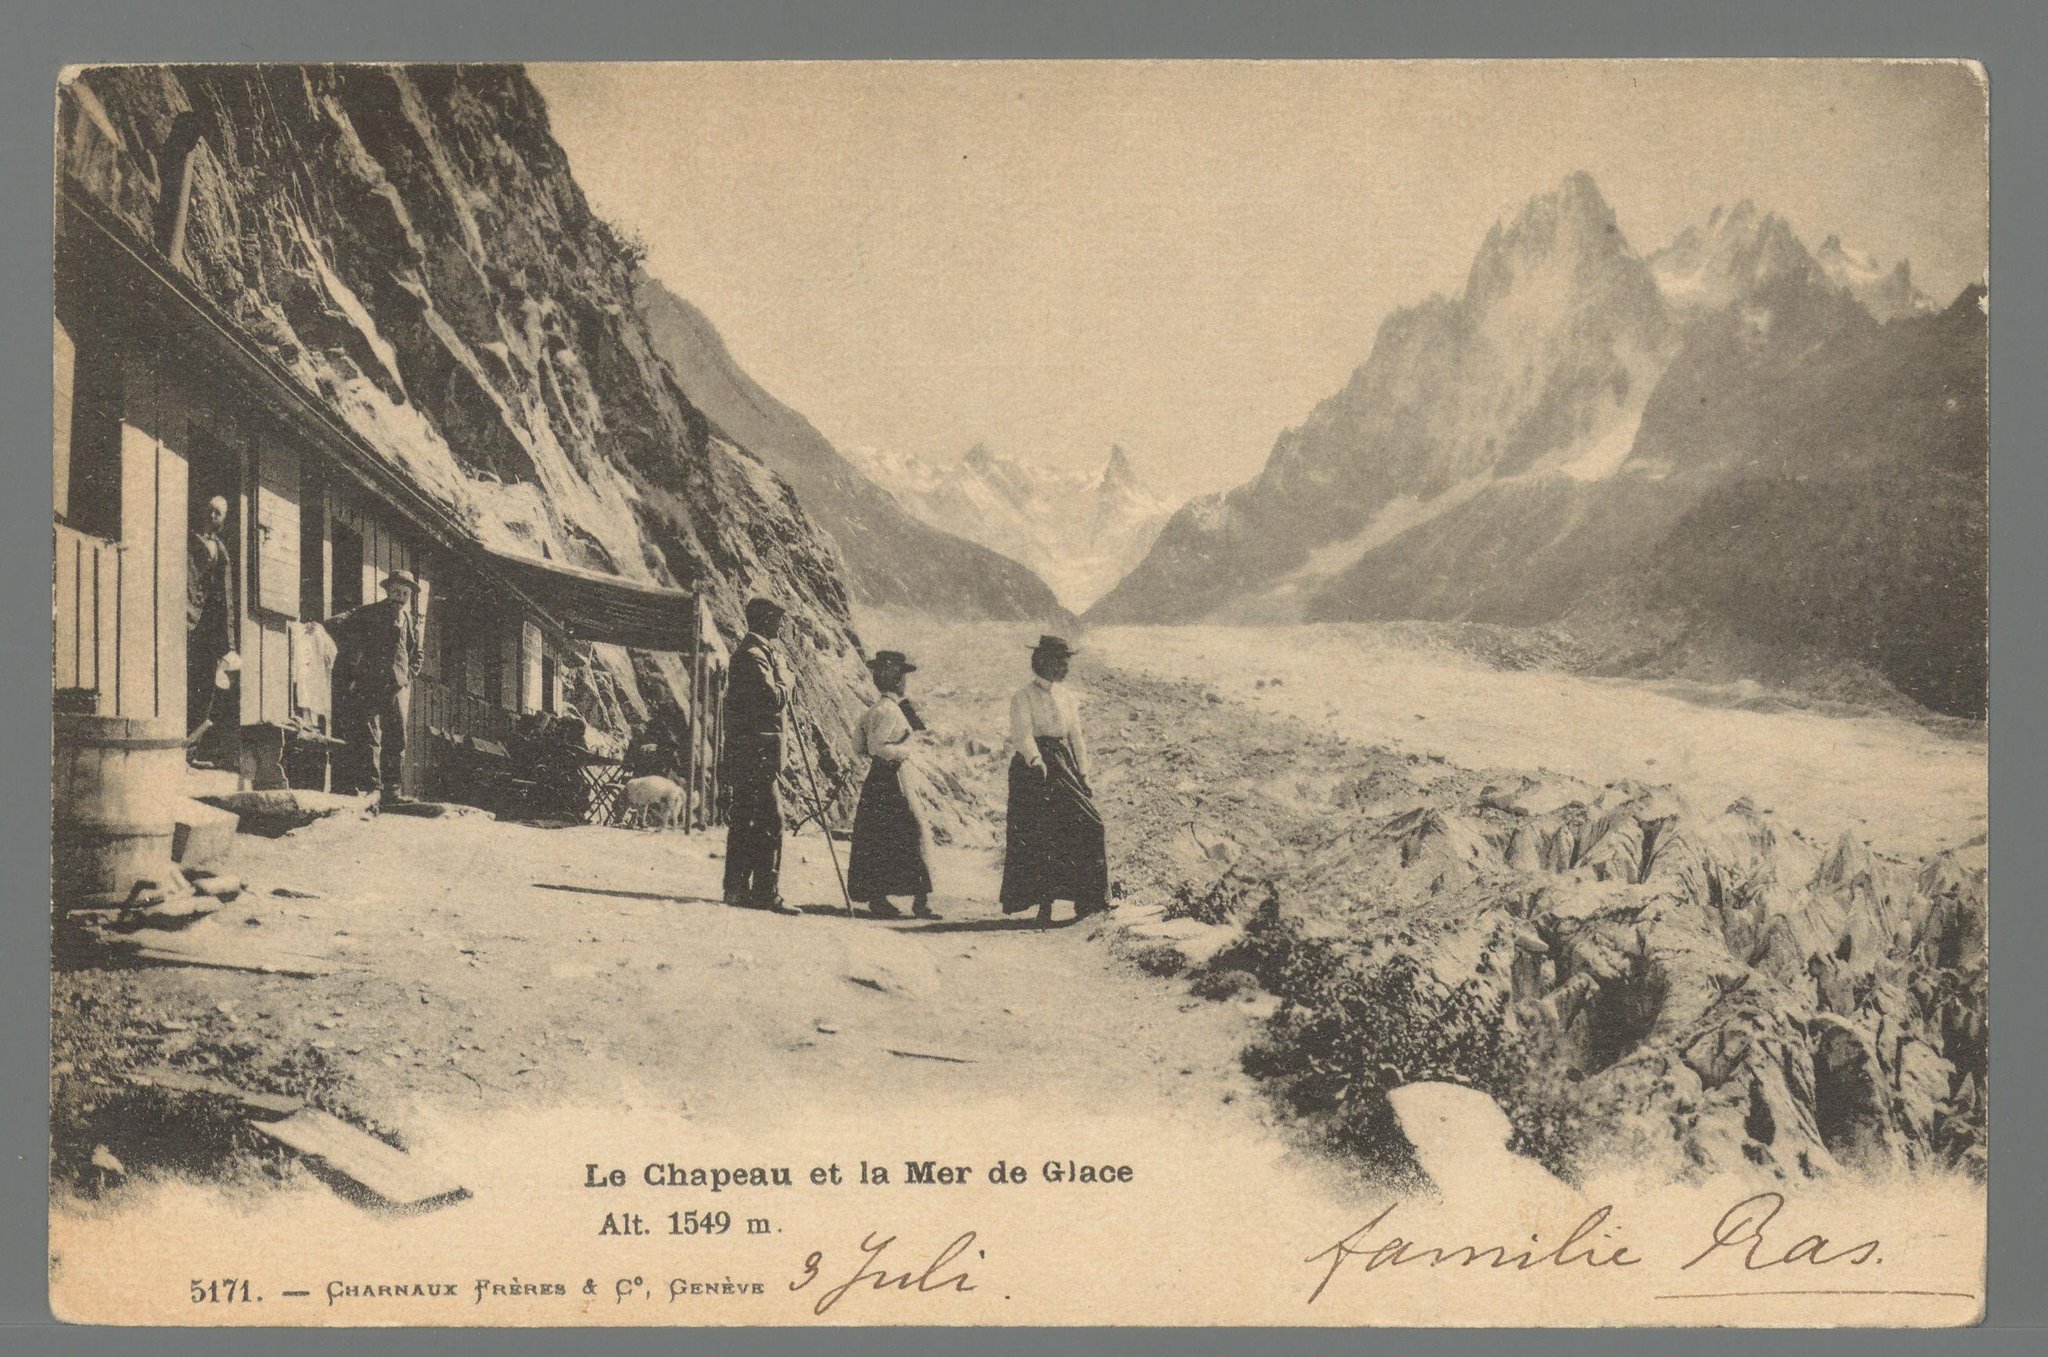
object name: photomechanical print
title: Le Chapeau et la Mer de Glace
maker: Anonymous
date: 1890-1901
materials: cardboard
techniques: photograph, writing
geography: chamonix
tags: mountain-range, snow peaks (+ landscape with figures, staffage), glacier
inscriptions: postage stamp